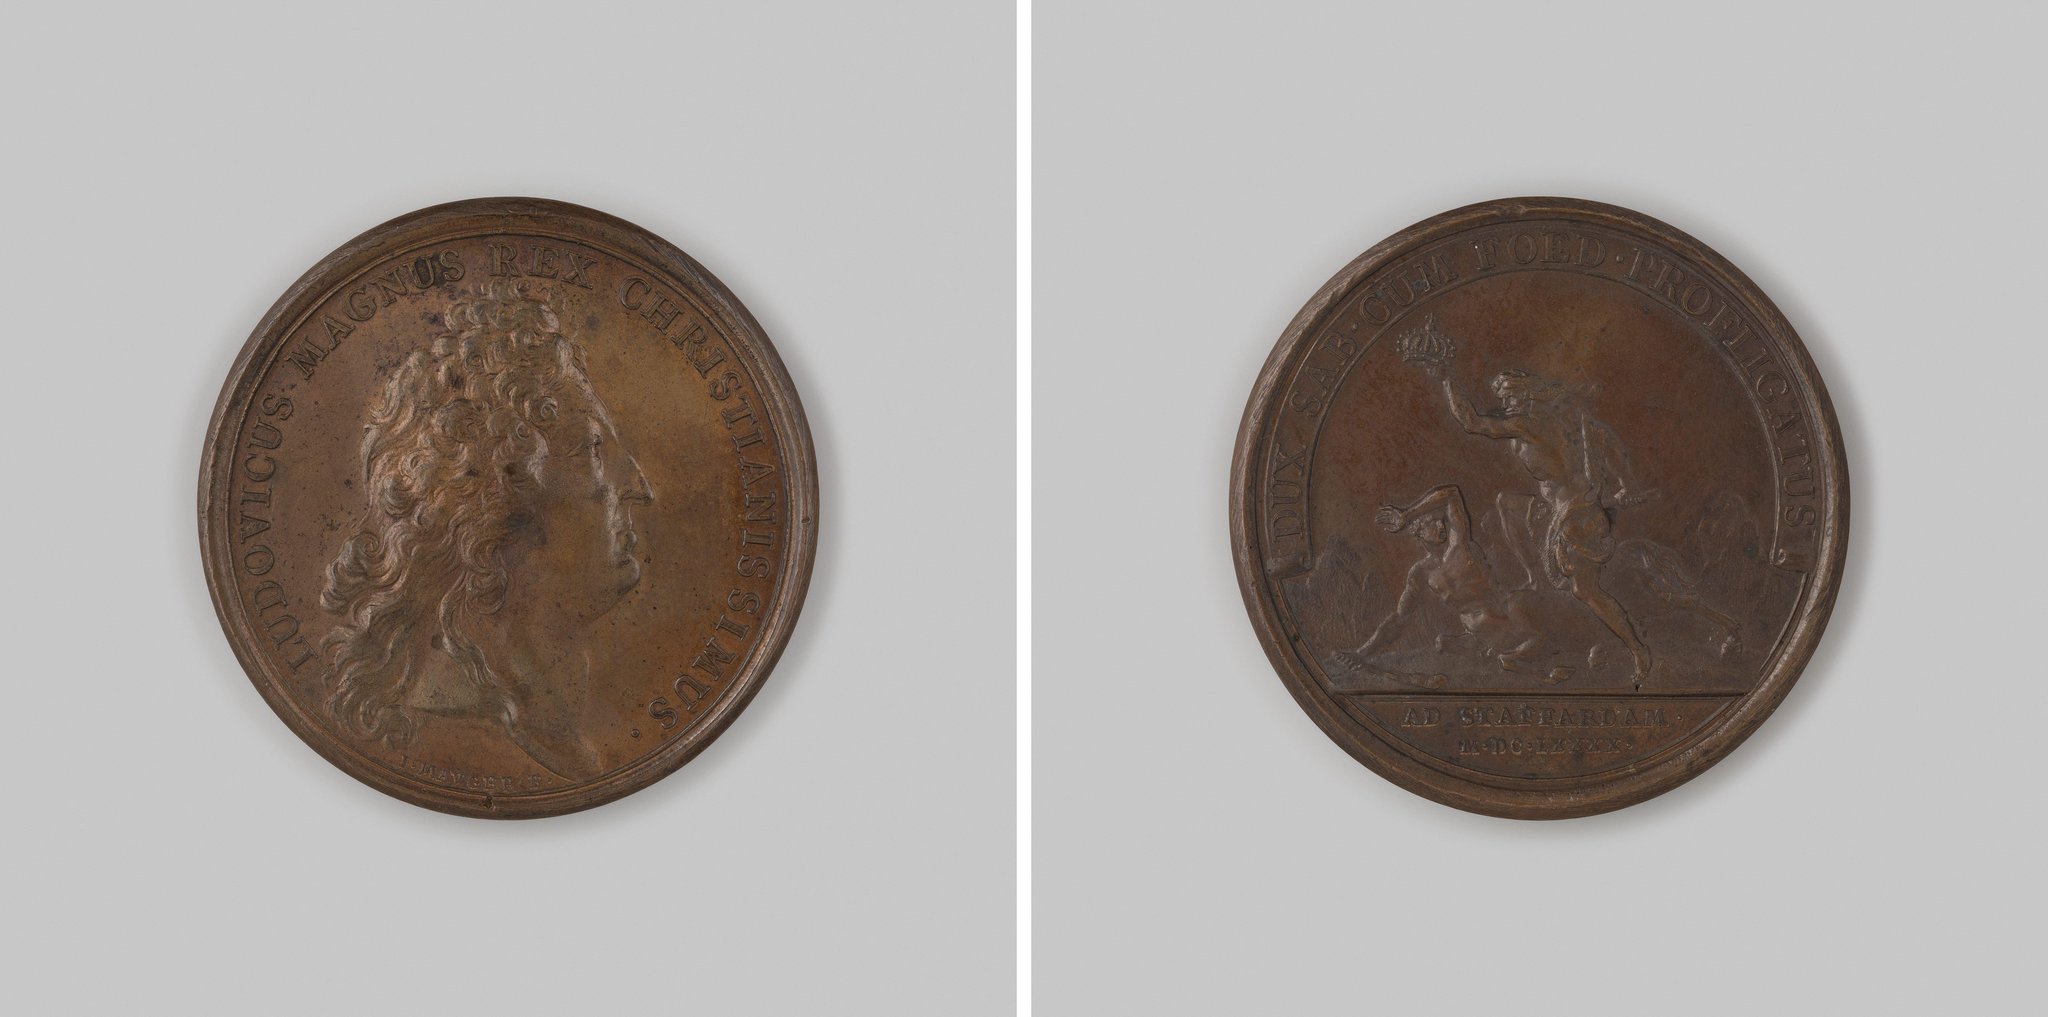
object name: history medal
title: Overwinning op de hertog van Savoye in de slag bij Staffard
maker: jean mauger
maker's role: medailleur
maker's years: 1648-1722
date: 1699-1703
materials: bronze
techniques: striking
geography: paris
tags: lodewijk xiv (koning van frankrijk)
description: Bronzen penning. Voorzijde: borststuk man binnen omschrift. Keerzijde: Herkules vertrapt centaur en ontneemt hem kroon binnen omschrift